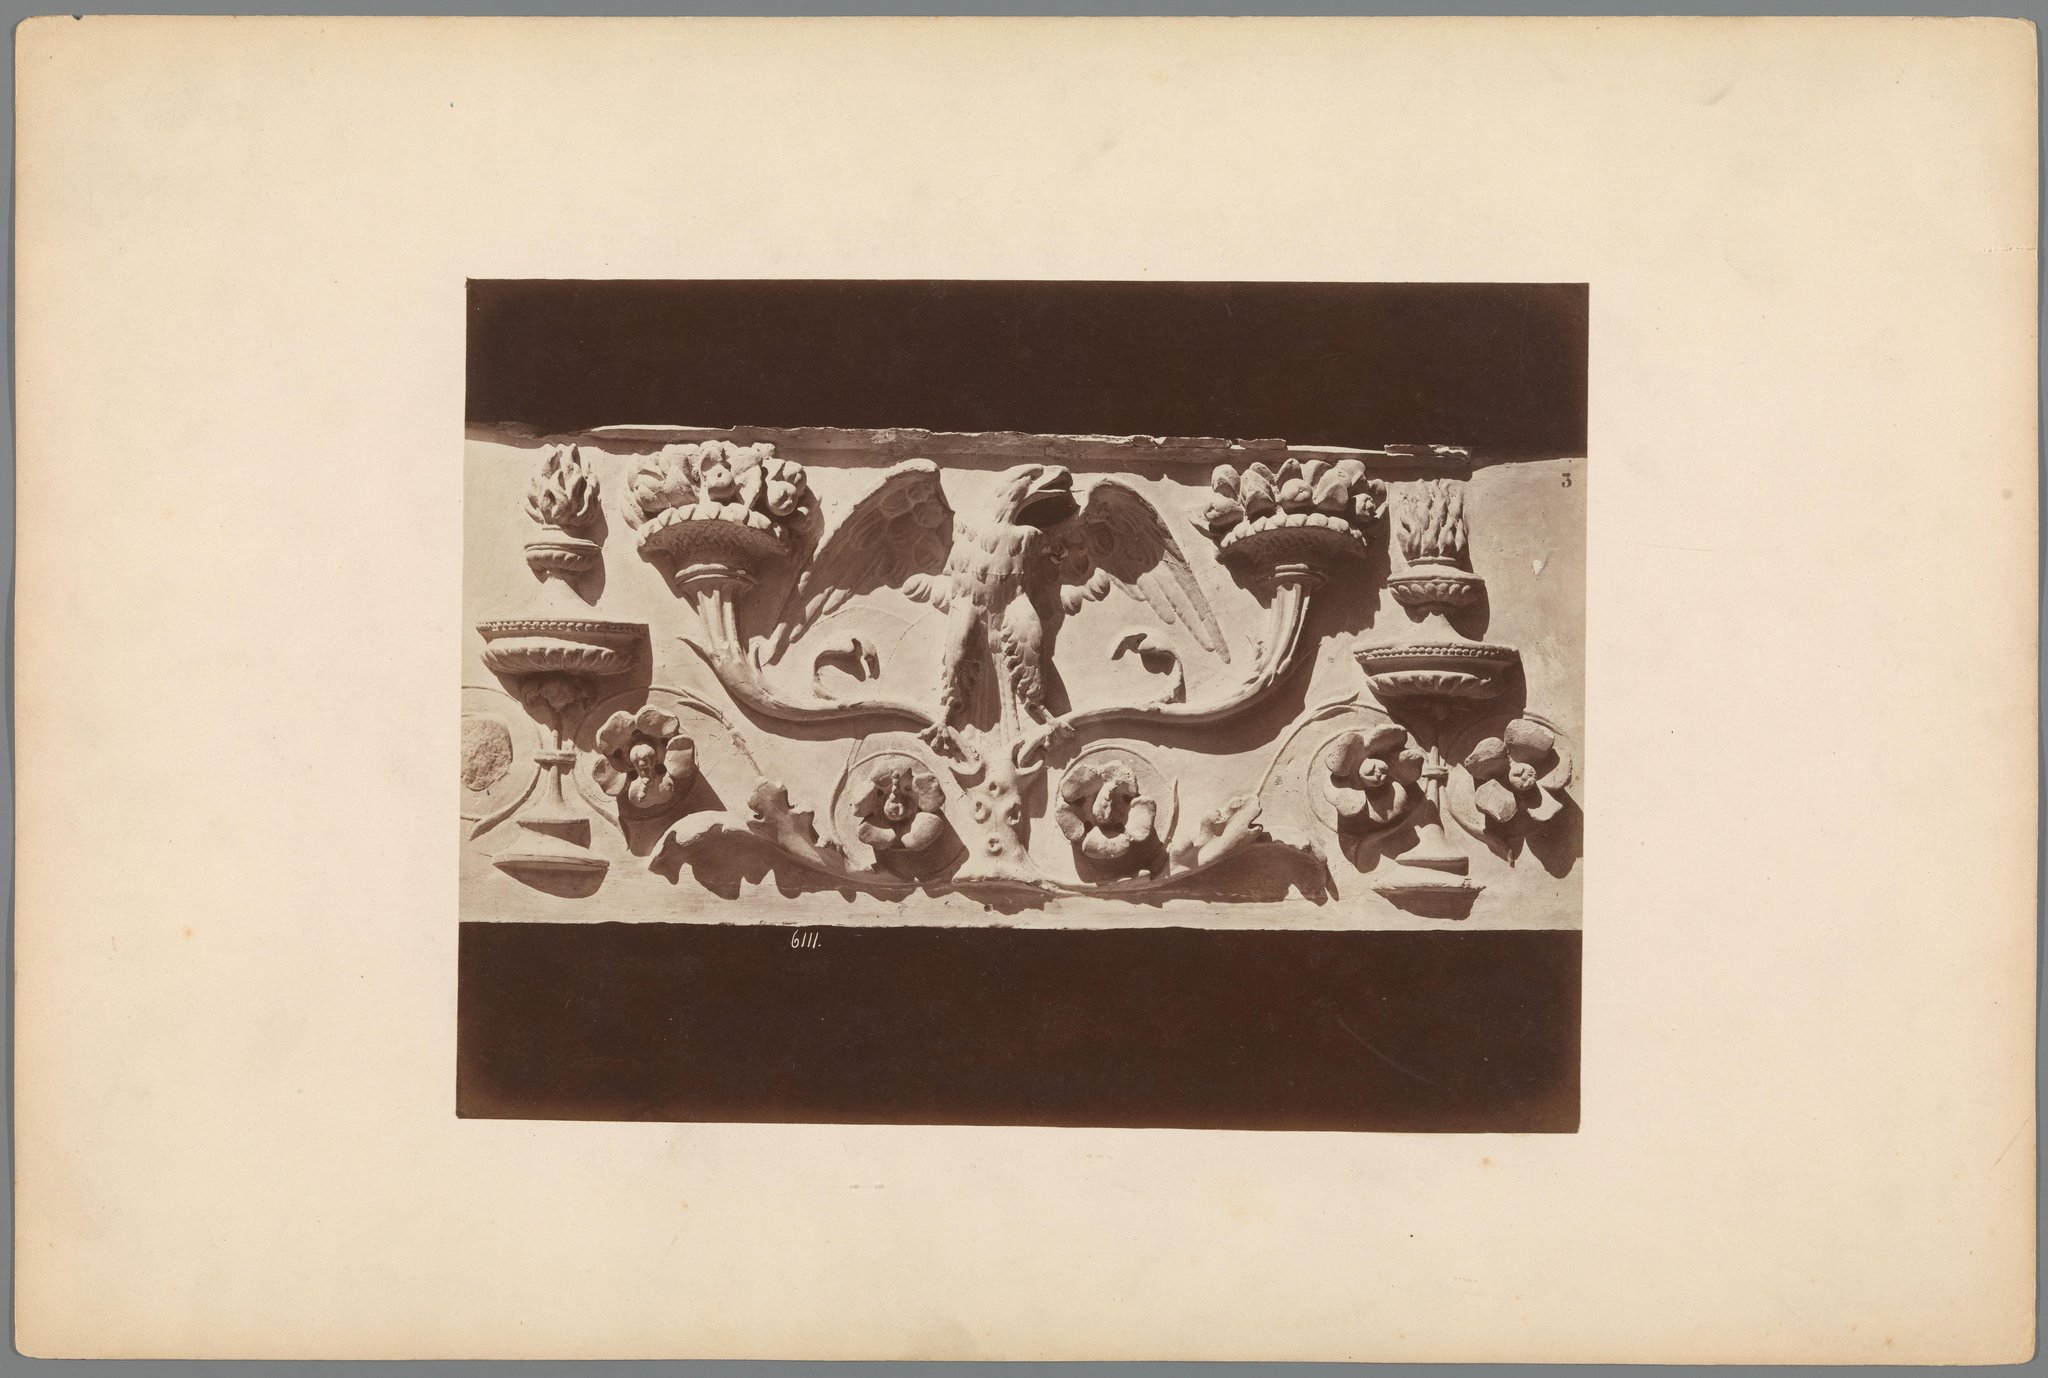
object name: photograph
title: Reliëf met een adelaar en kandelaars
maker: Anonymous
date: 1875-1900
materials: cardboard, photographic support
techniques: albumen print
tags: predatory birds: eagle, chandelier, candelabrum, flowers ~ ornament, sculpture (+ relief ~ sculpture)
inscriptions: number: ‘6111.’, collector's mark: Lugt 3937